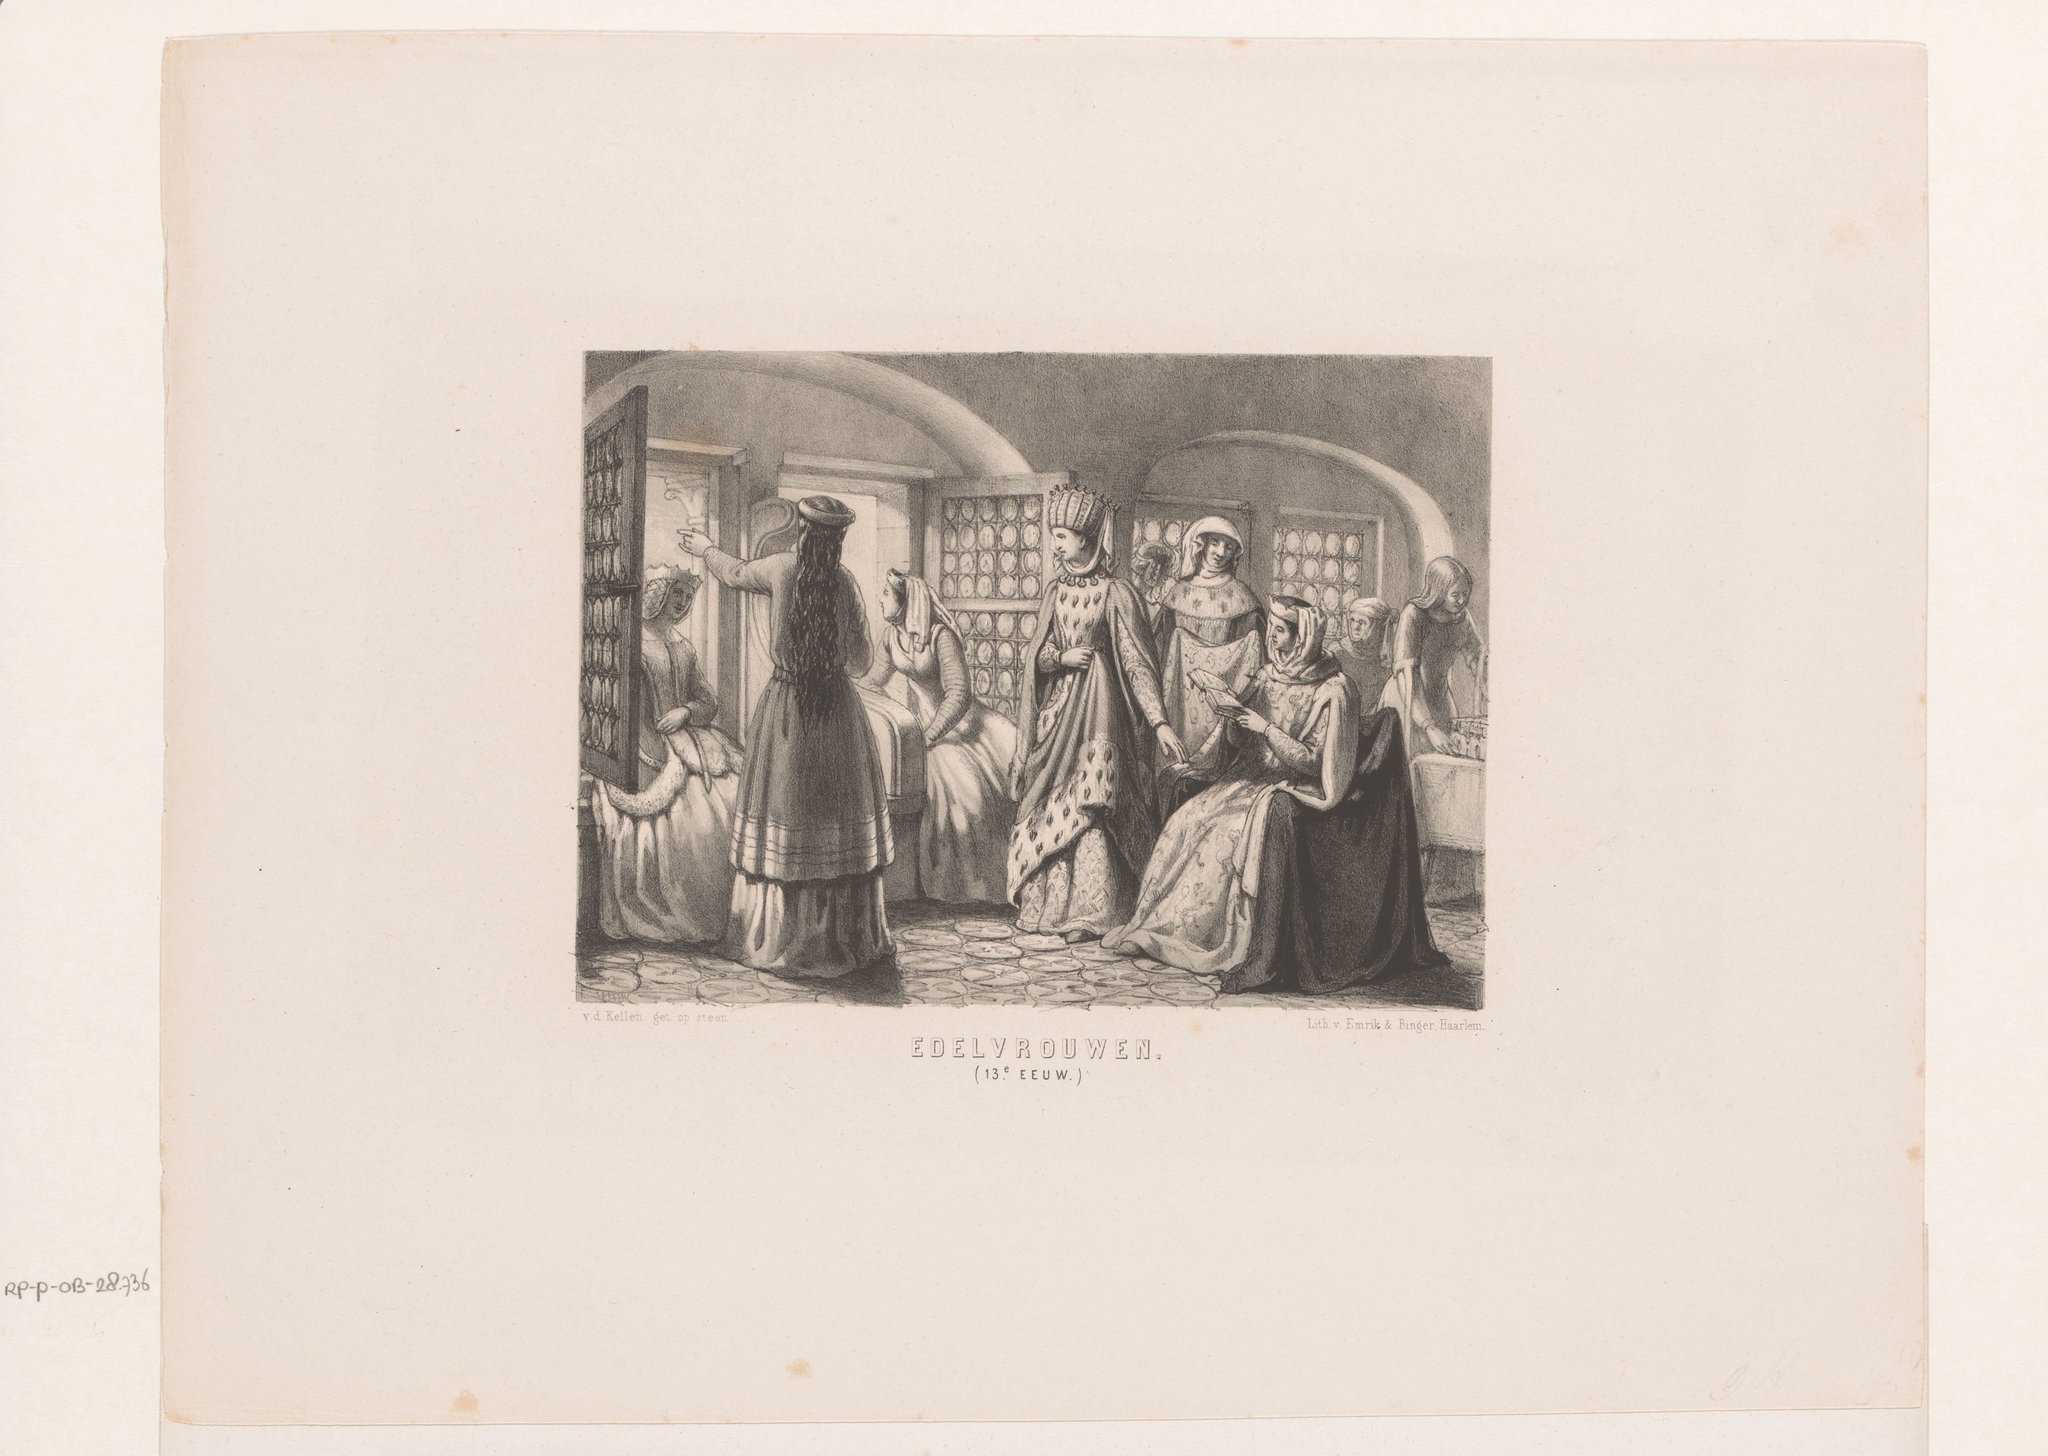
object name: costume print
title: Edelvrouwen, 13e eeuw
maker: david van der kellen (1827-1895)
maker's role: draughtsman, print maker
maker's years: 1827-1895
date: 1857-1864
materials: paper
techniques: tone lithography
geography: haarlem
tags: clothes, costume (+ women's clothes), nobility and patriciate; chivalry, knighthood, netherlands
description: Illustratie voor: W.J. Hofdijk, Ons voorgeslacht in zijn dagelyksch leven geschilderd, Kruseman, Haarlem 1859-1864.